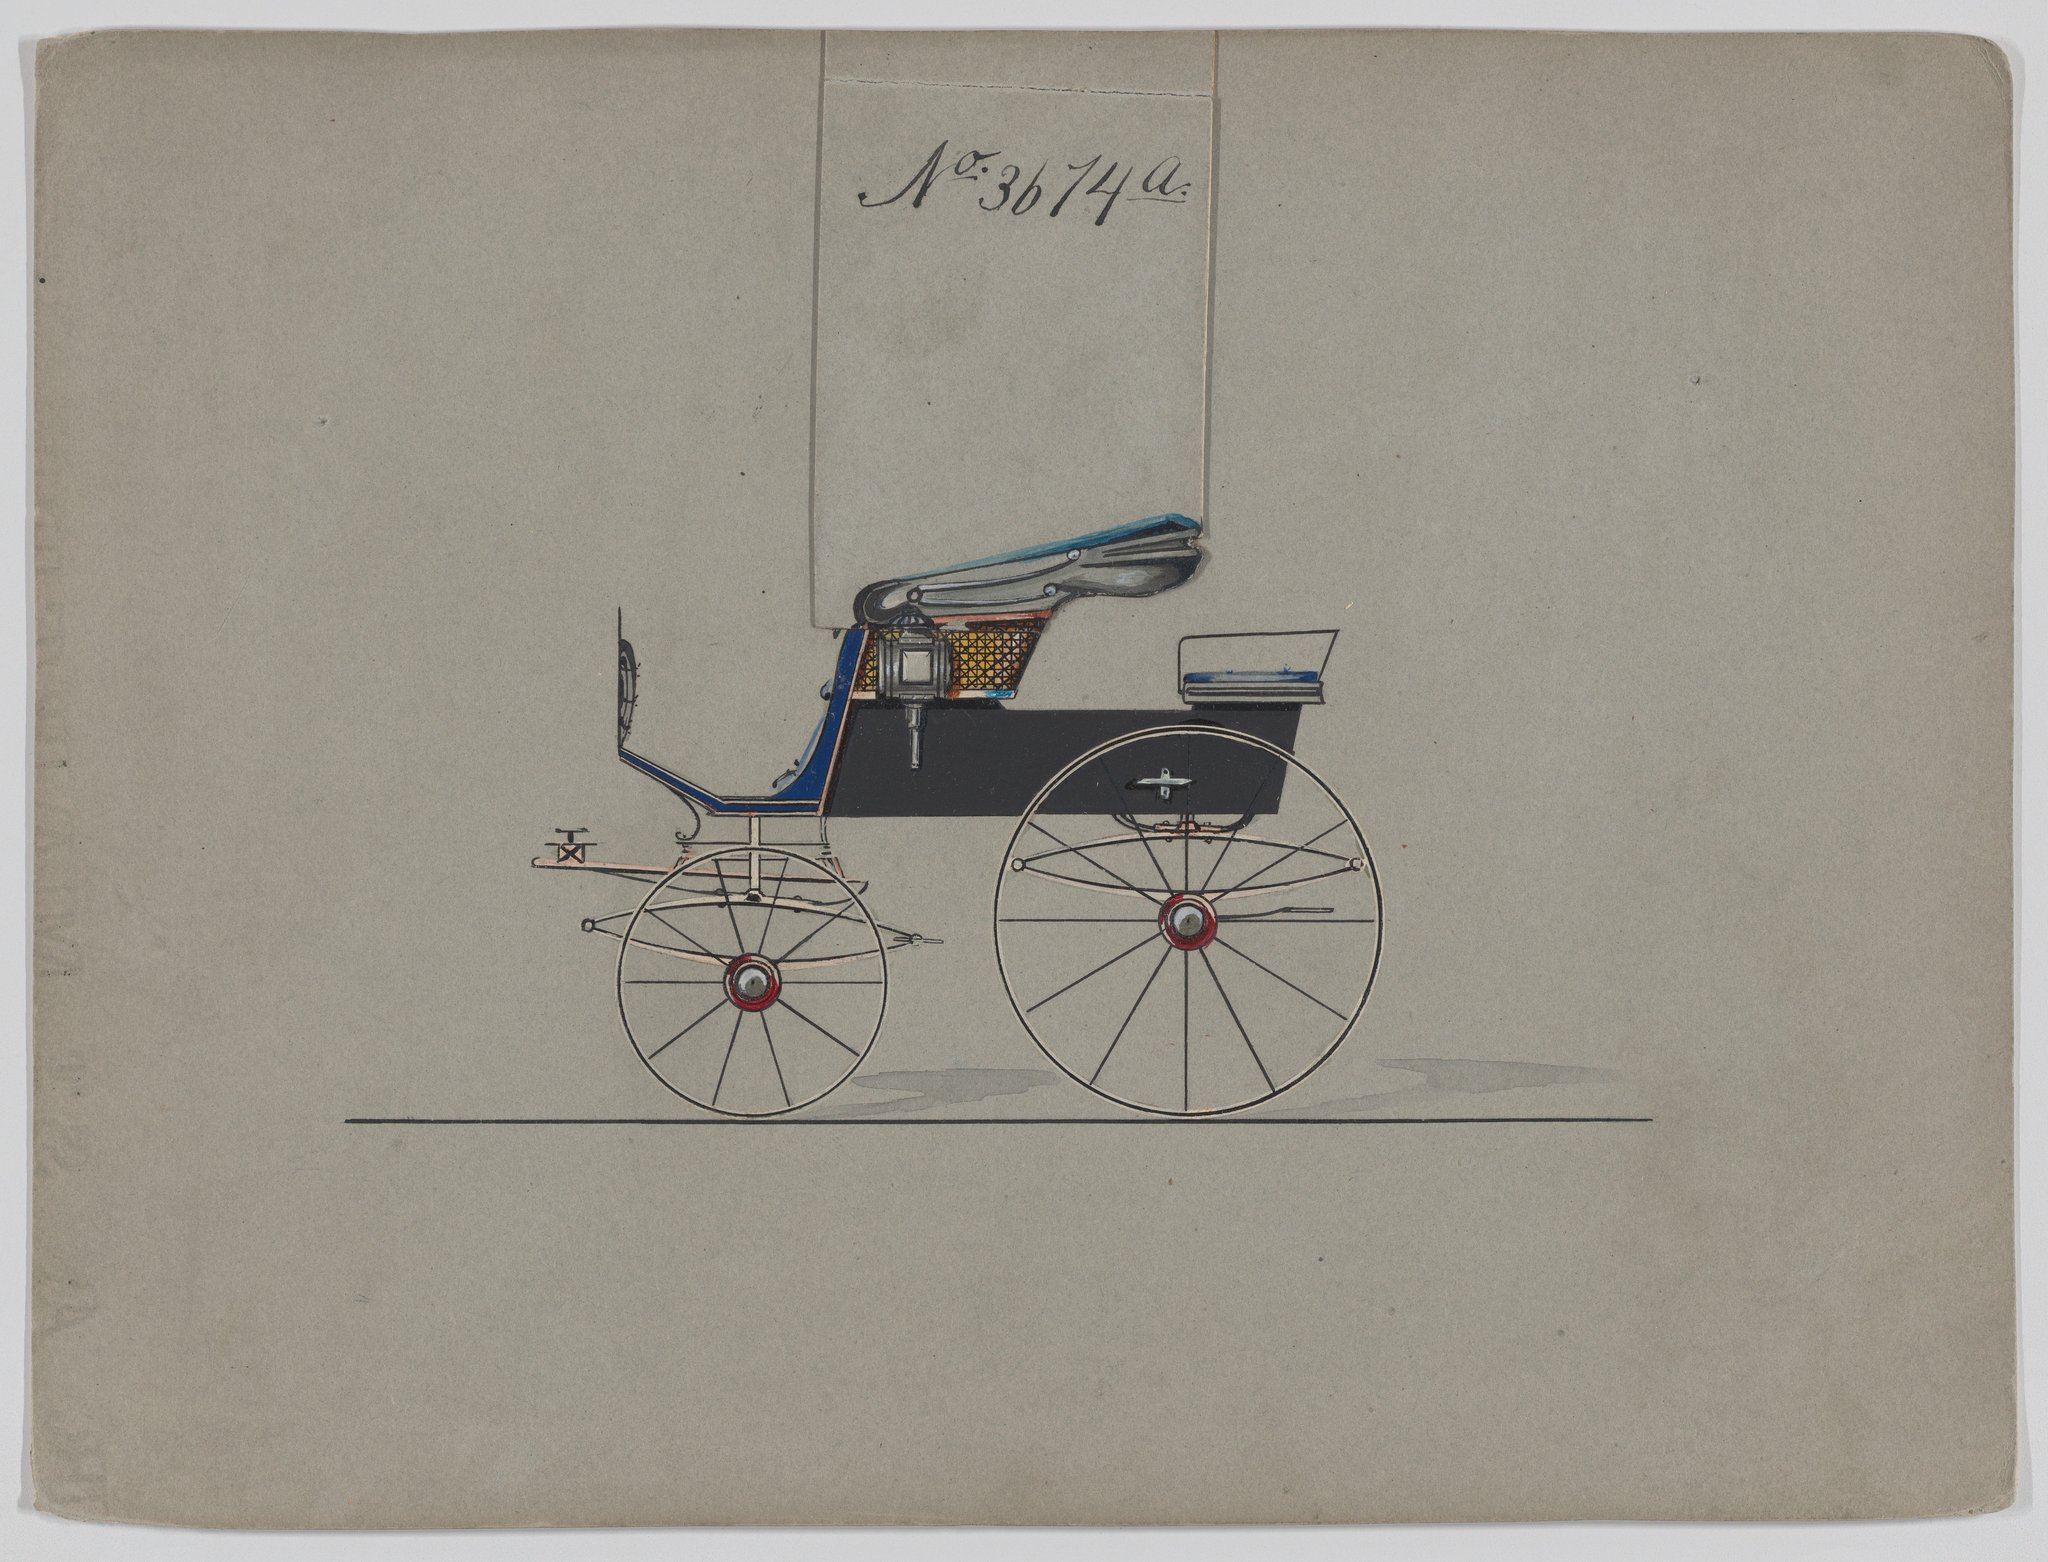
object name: drawing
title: Design for Stanhope Phaeton, no. 3674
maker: brewster & co.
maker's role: manufacturer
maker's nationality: american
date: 1881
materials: gouache, gum arabic, ink, watercolor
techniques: pen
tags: carriages